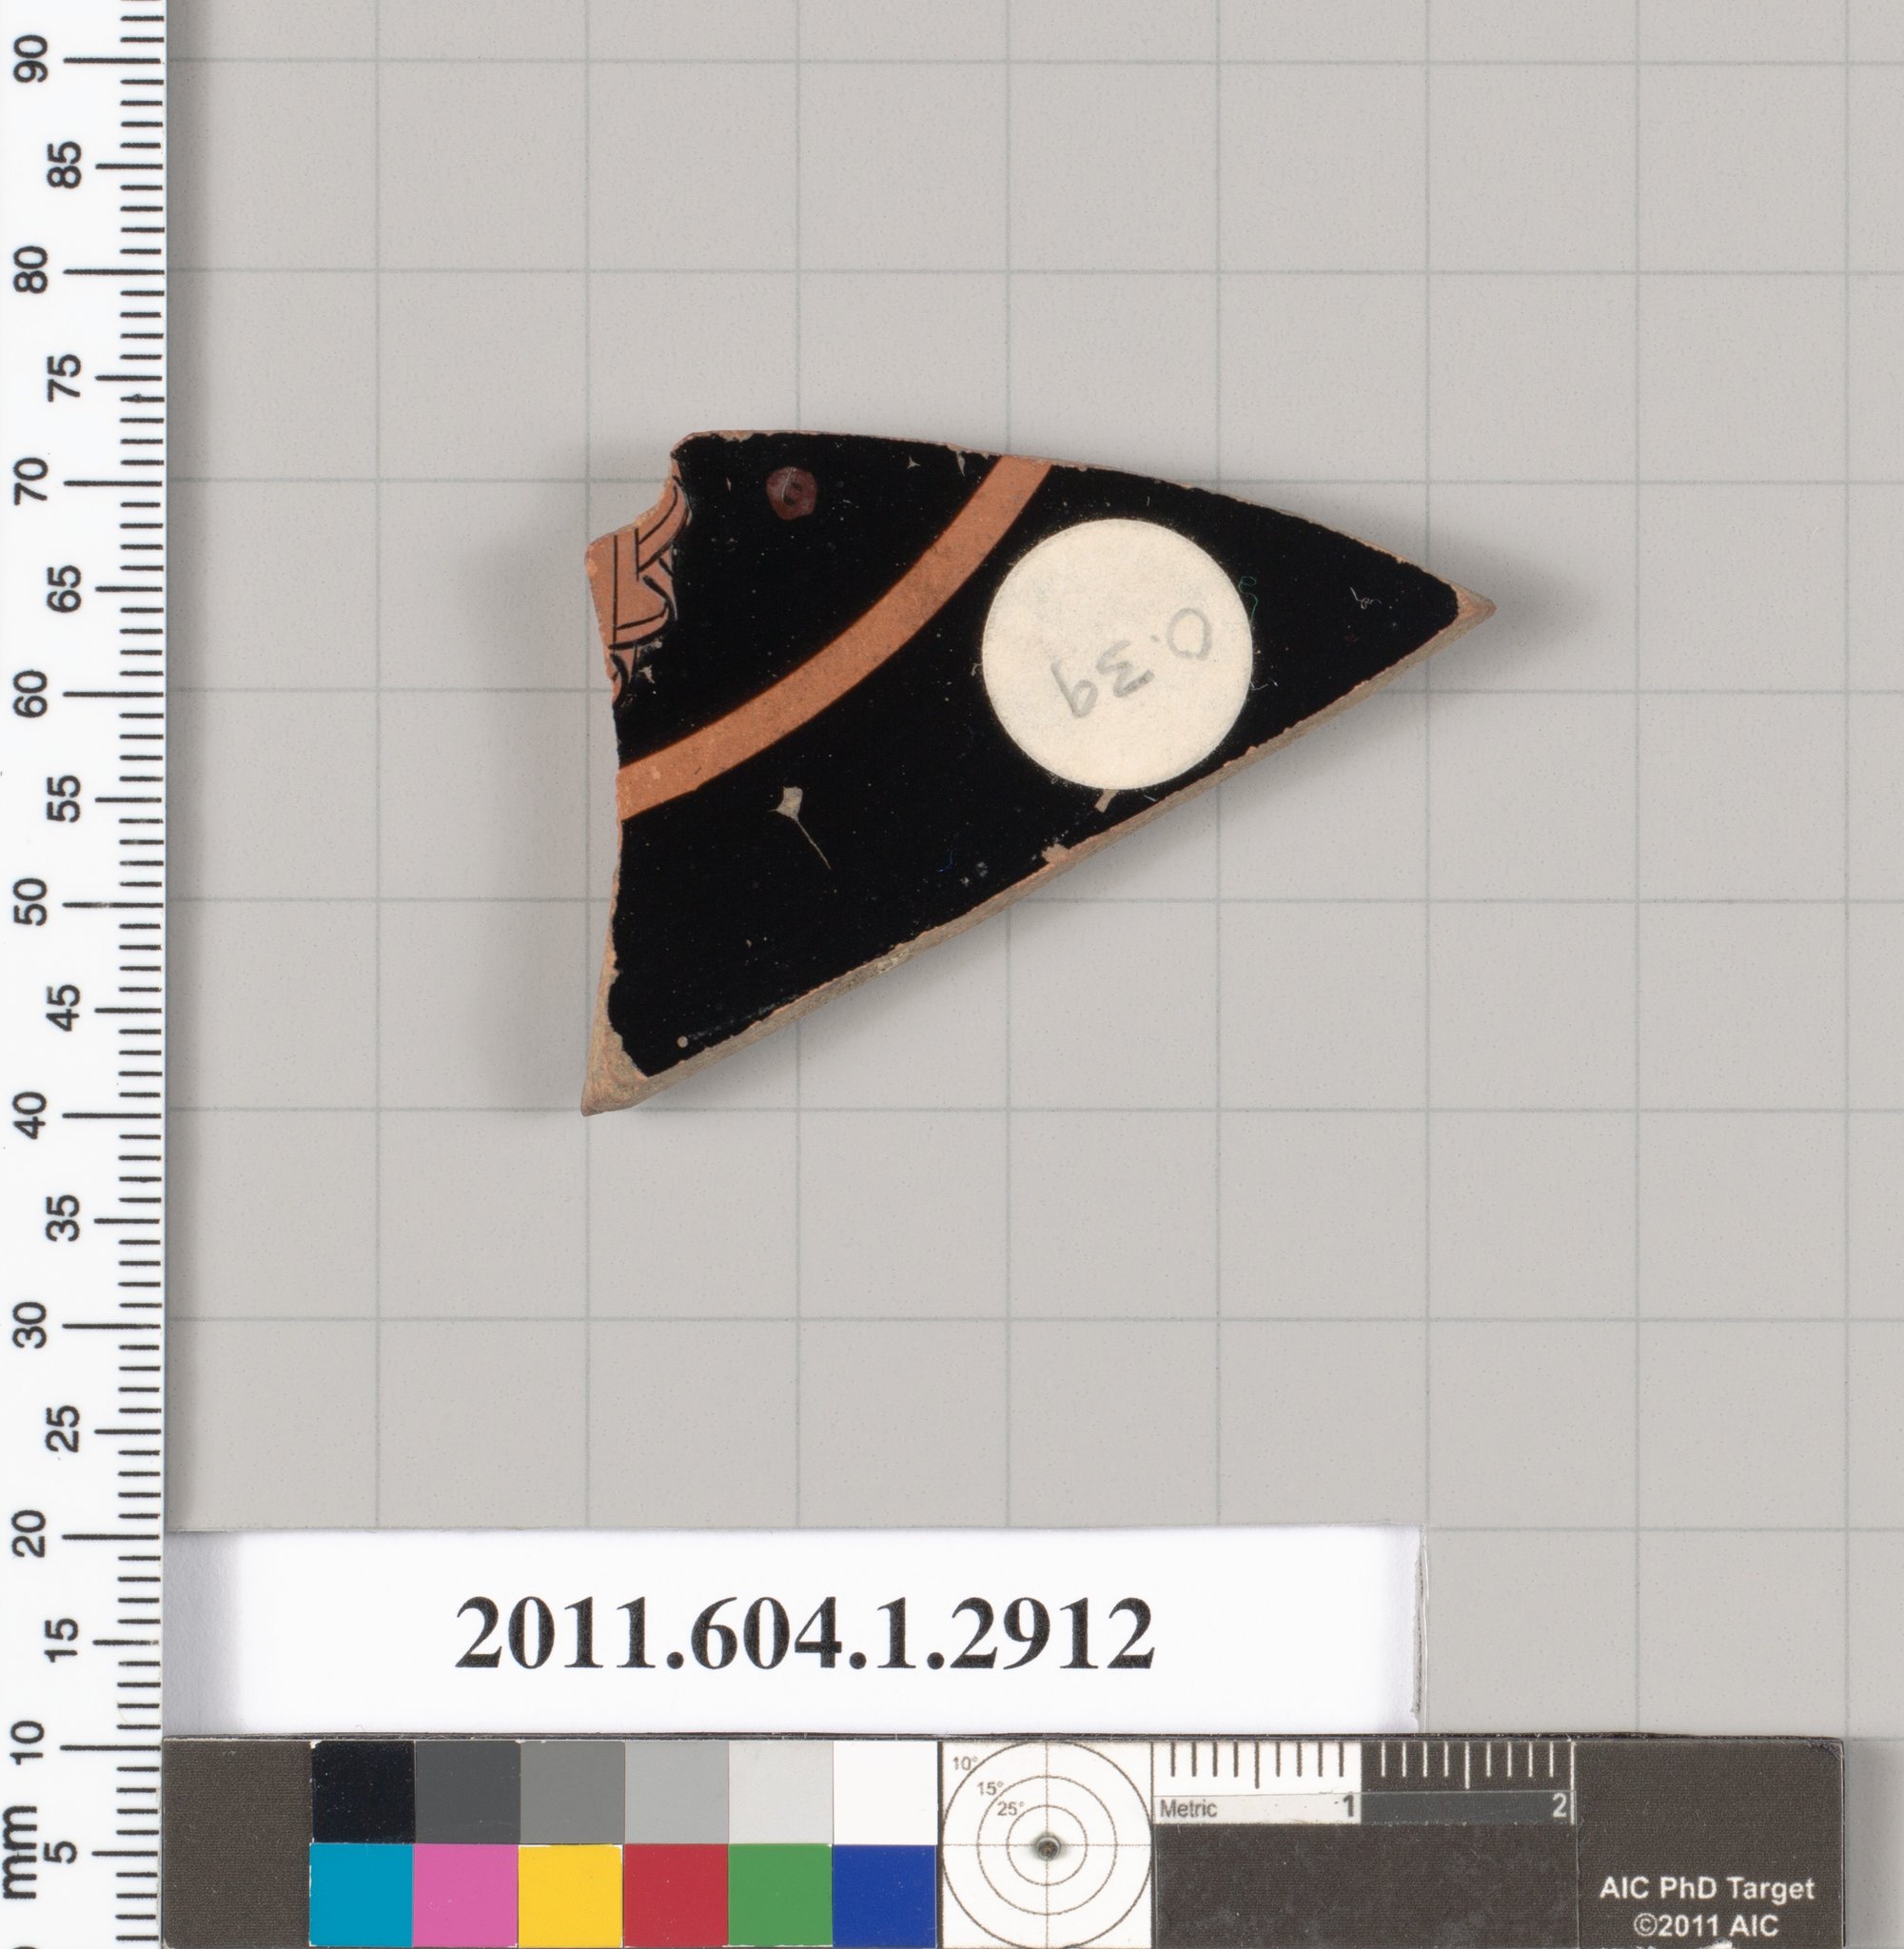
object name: kylix fragment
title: Terracotta fragment of a kylix (drinking cup)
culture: greek, attic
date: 490-480 BCE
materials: terracotta